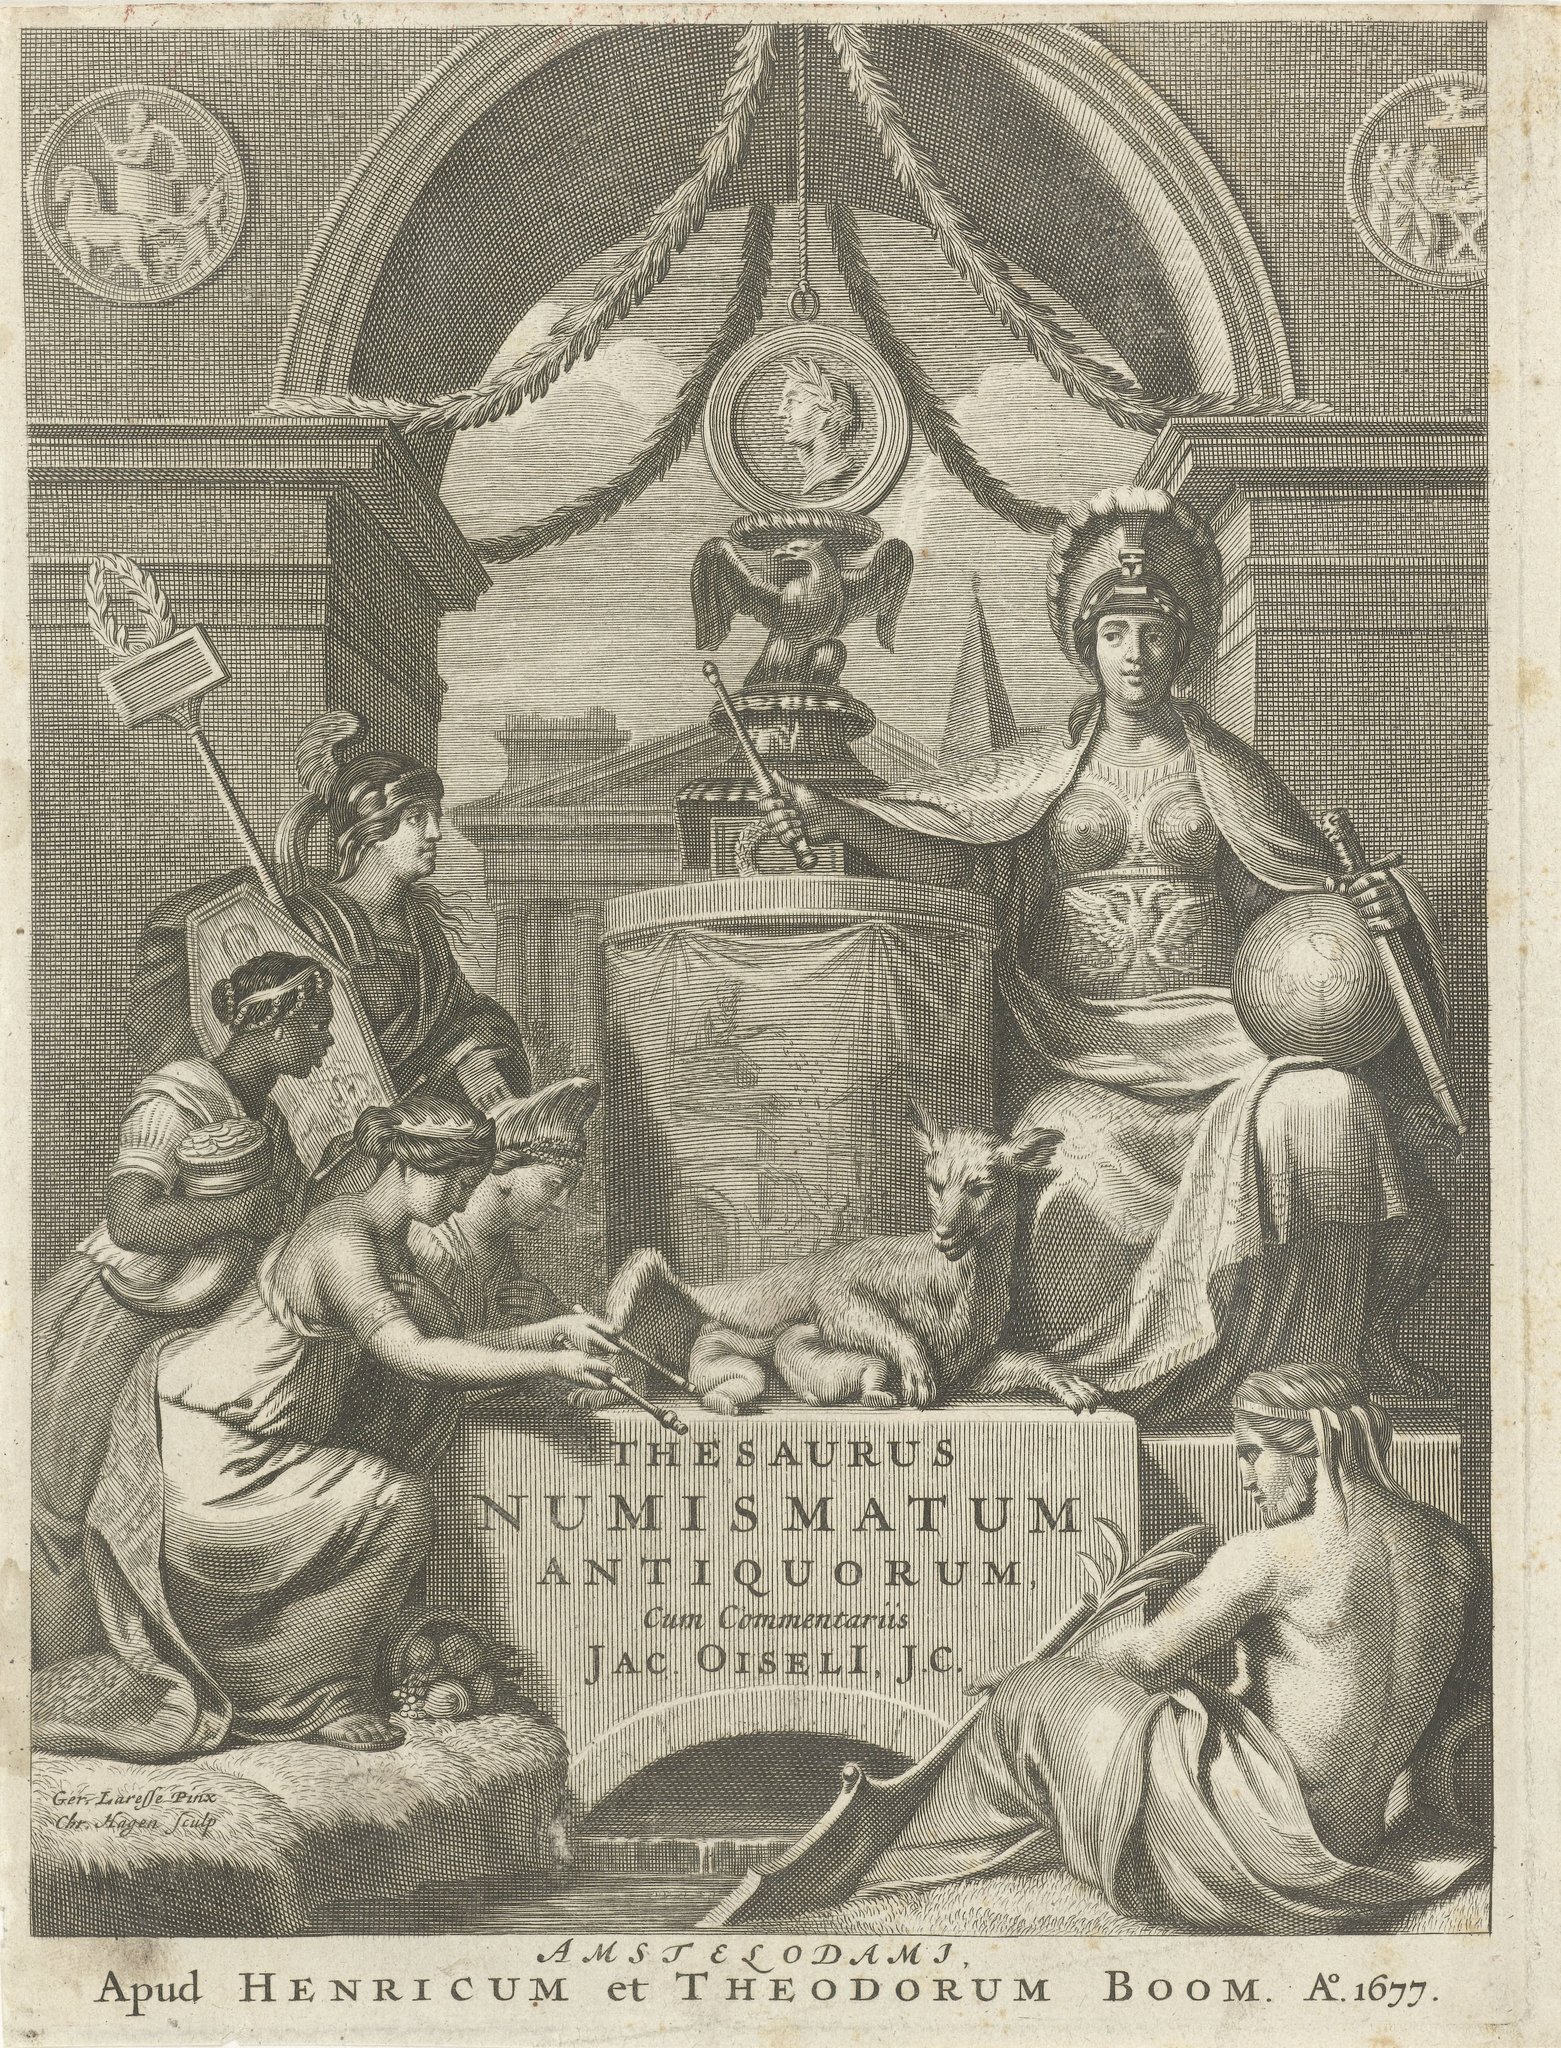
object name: titelblad, titelpagina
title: Titelpagina voor: J. Oisel, Thesaurus selectorum numismatum antiquorum, 1677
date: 1677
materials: paper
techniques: engraving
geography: amsterdam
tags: sceptre, staff (symbol of sovereignty), triumphal arch, crowning with laurel (+ wreath, garland ~ festive activities), infancy, upbringing of romulus and remus, ideal and visionary architecture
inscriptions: collector's mark: Lugt 2228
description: Onder een triomfboog zit rechts een allegorische vrouwenfiguur met zwaard, wereldbol en scepter. Zij draagt een helm op het hoofd. Links vier figuren. In het midden de titel met daarboven een liggende wolvin, die Romulus en Remus voedt. Op de voorgrond een zittende riviergod aan het water. Onderaan twee regels in het Latijn.